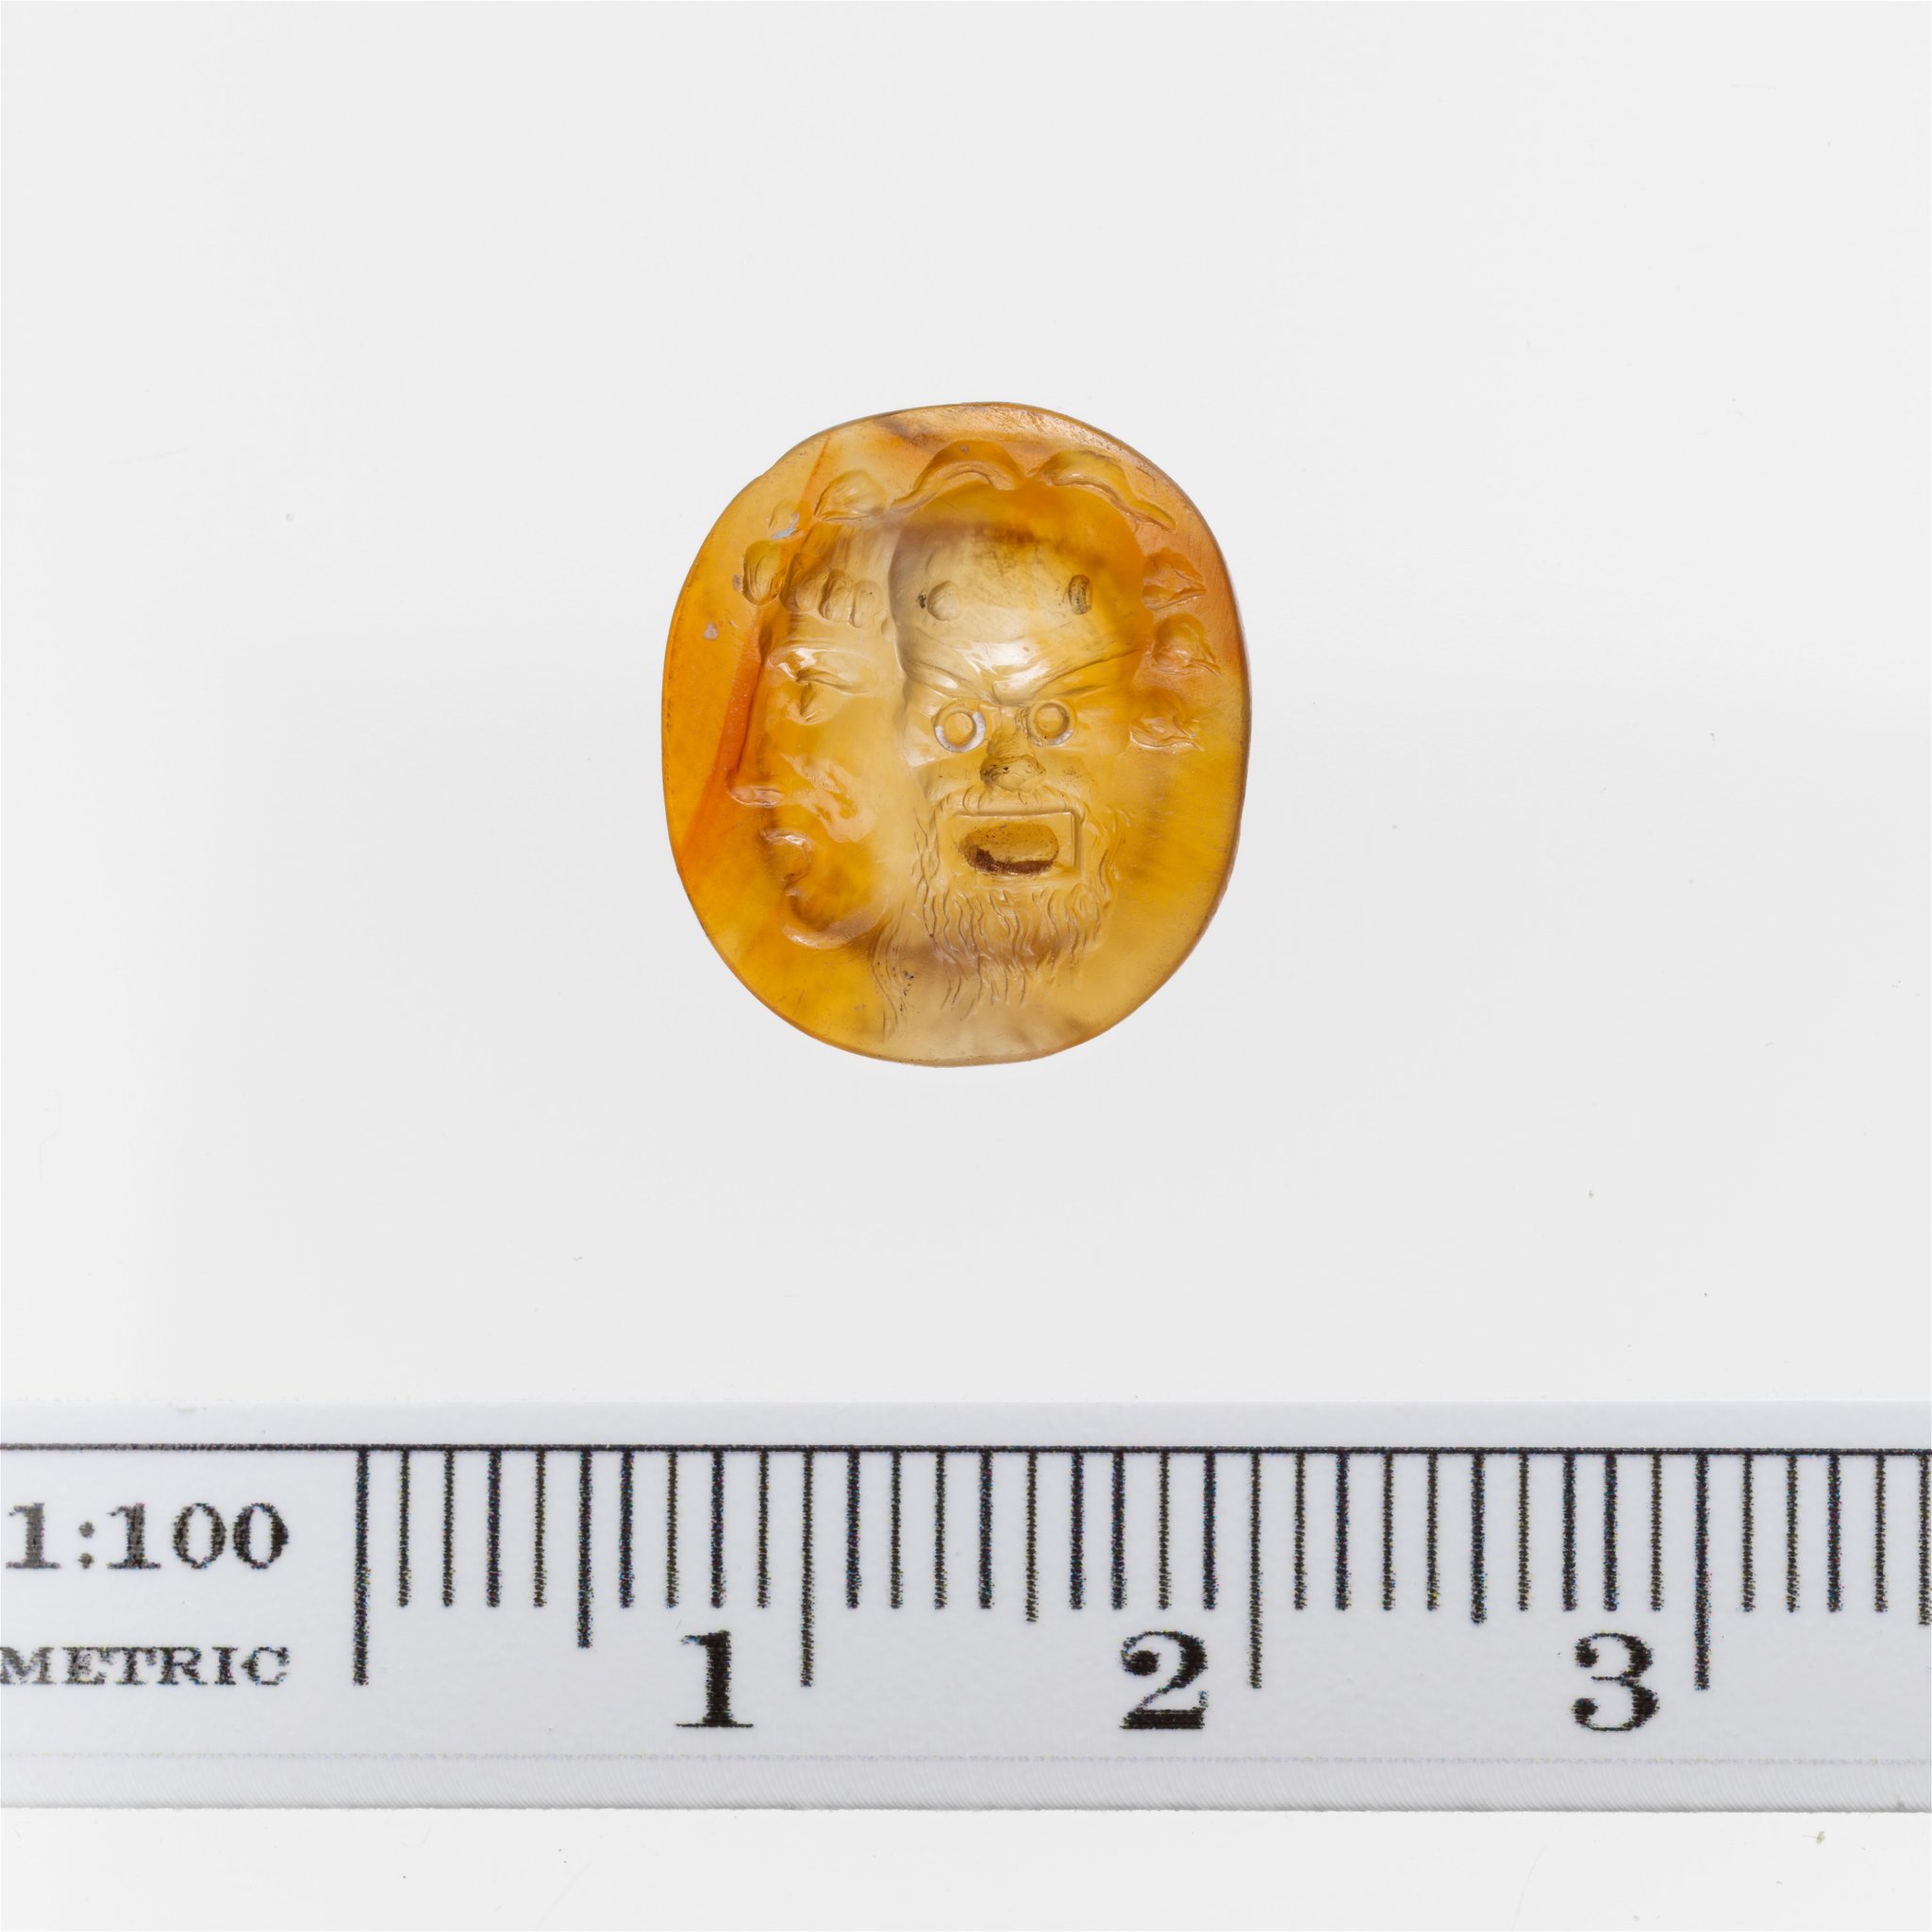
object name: intaglio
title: Sard ring stone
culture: roman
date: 1-100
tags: masks,women